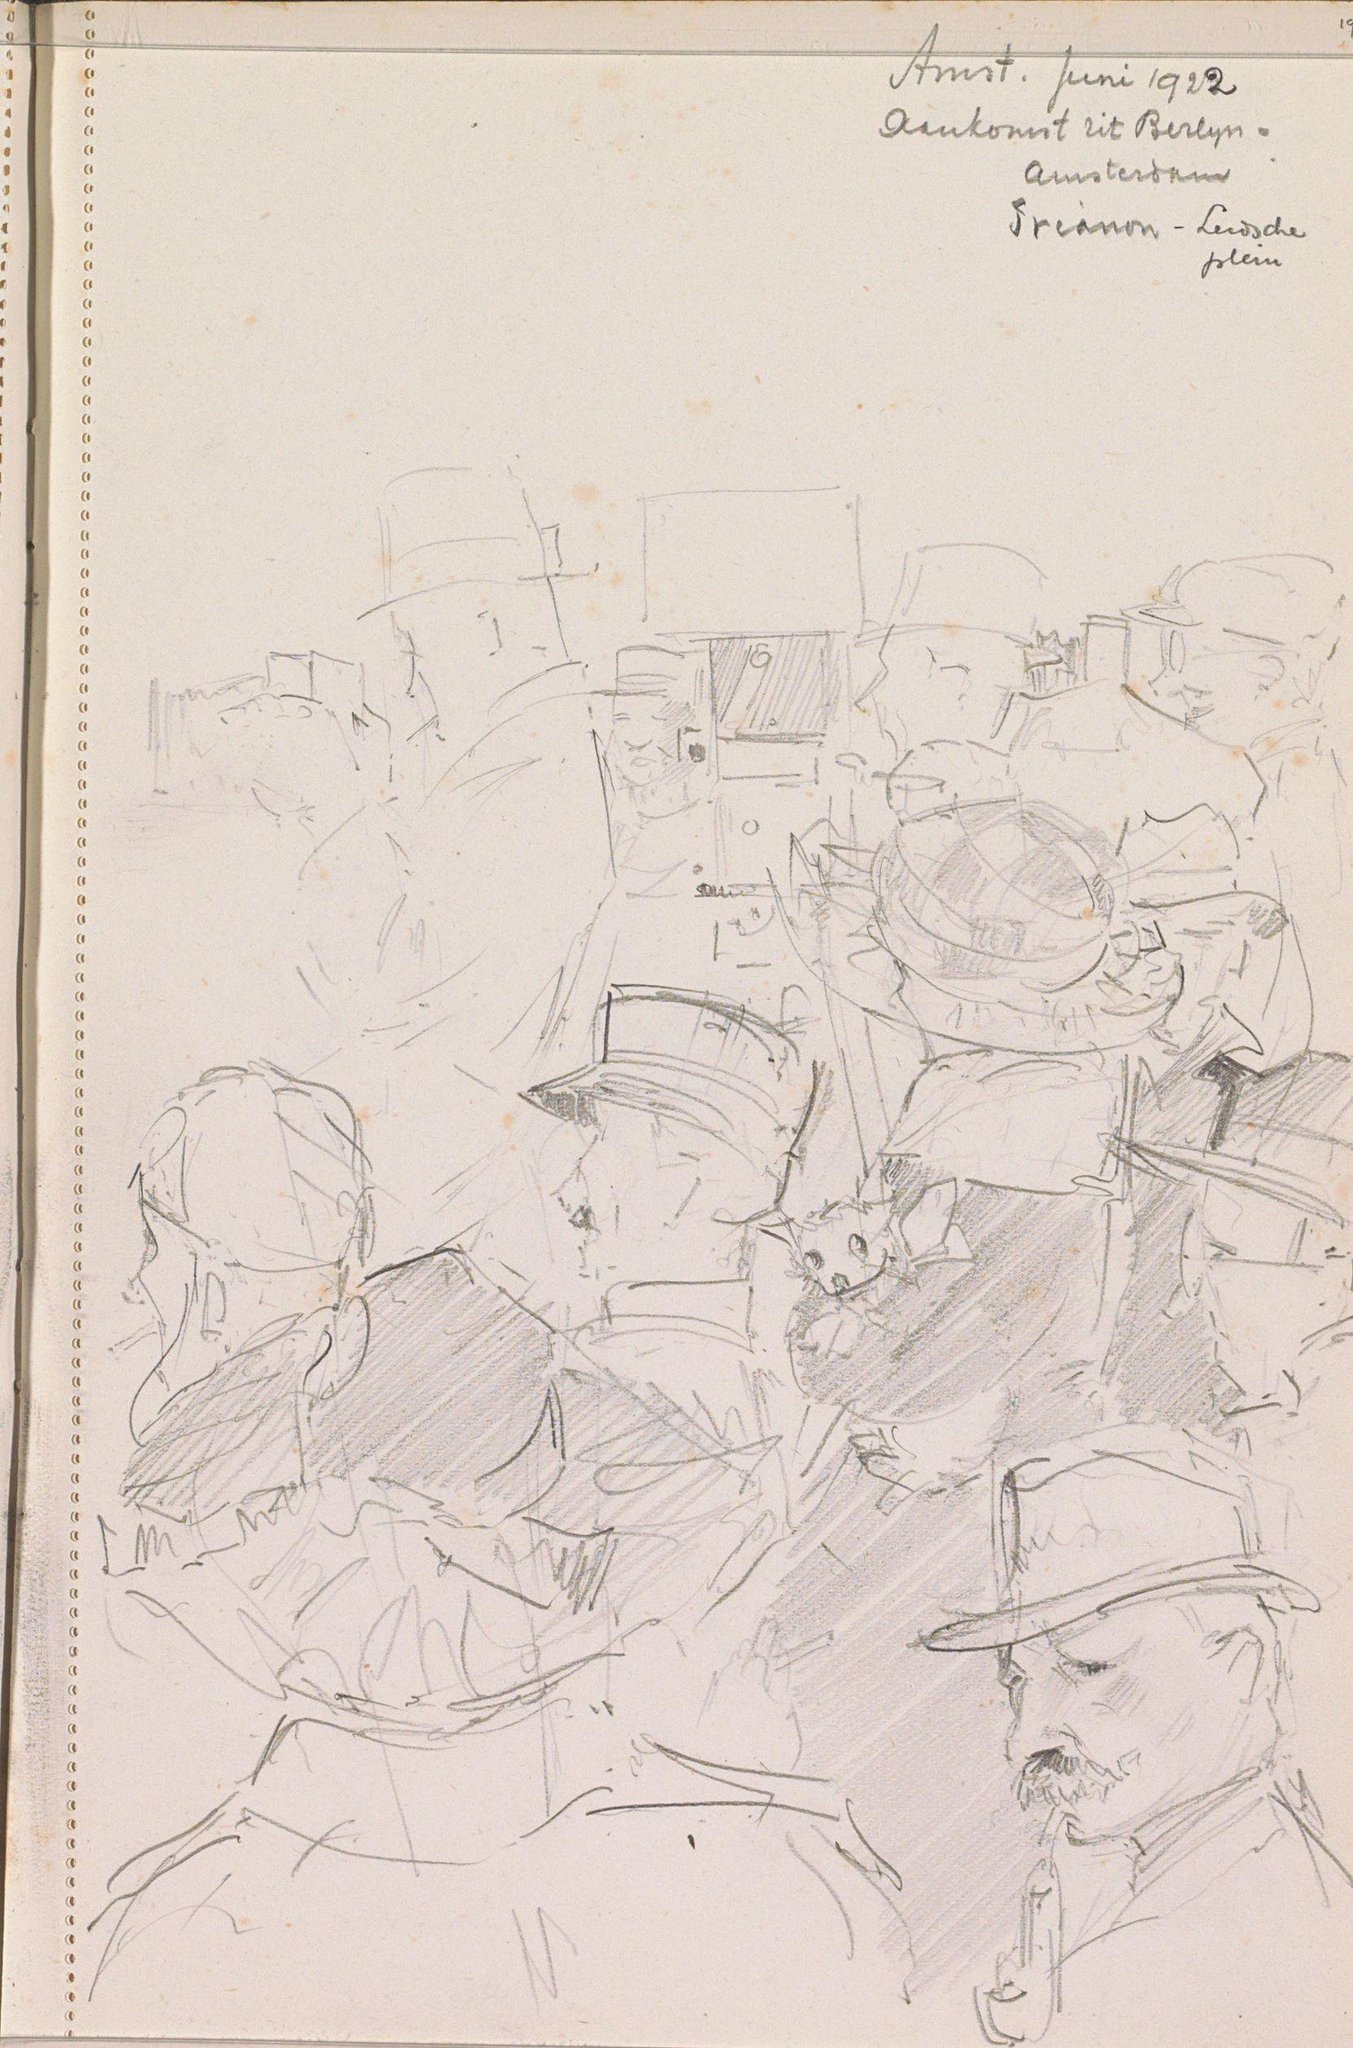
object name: sketchbook leaf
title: Toeschouwers bij restaurant Trianon op het Leidseplein te Amsterdam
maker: otto verhagen (i)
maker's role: draughtsman, print maker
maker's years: 1885-1951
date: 1906-1922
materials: paper, pencil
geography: amsterdam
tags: street (+ city(-scape) with figures, staffage), amsterdam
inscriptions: date and inscription: ‘Amst. Juni 1922/ aankomst rit Berlijn-/ Amsterdam/ Trianon - Leidsche/ plein’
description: Pagina 19 uit een schetsboek met 34 bladen.